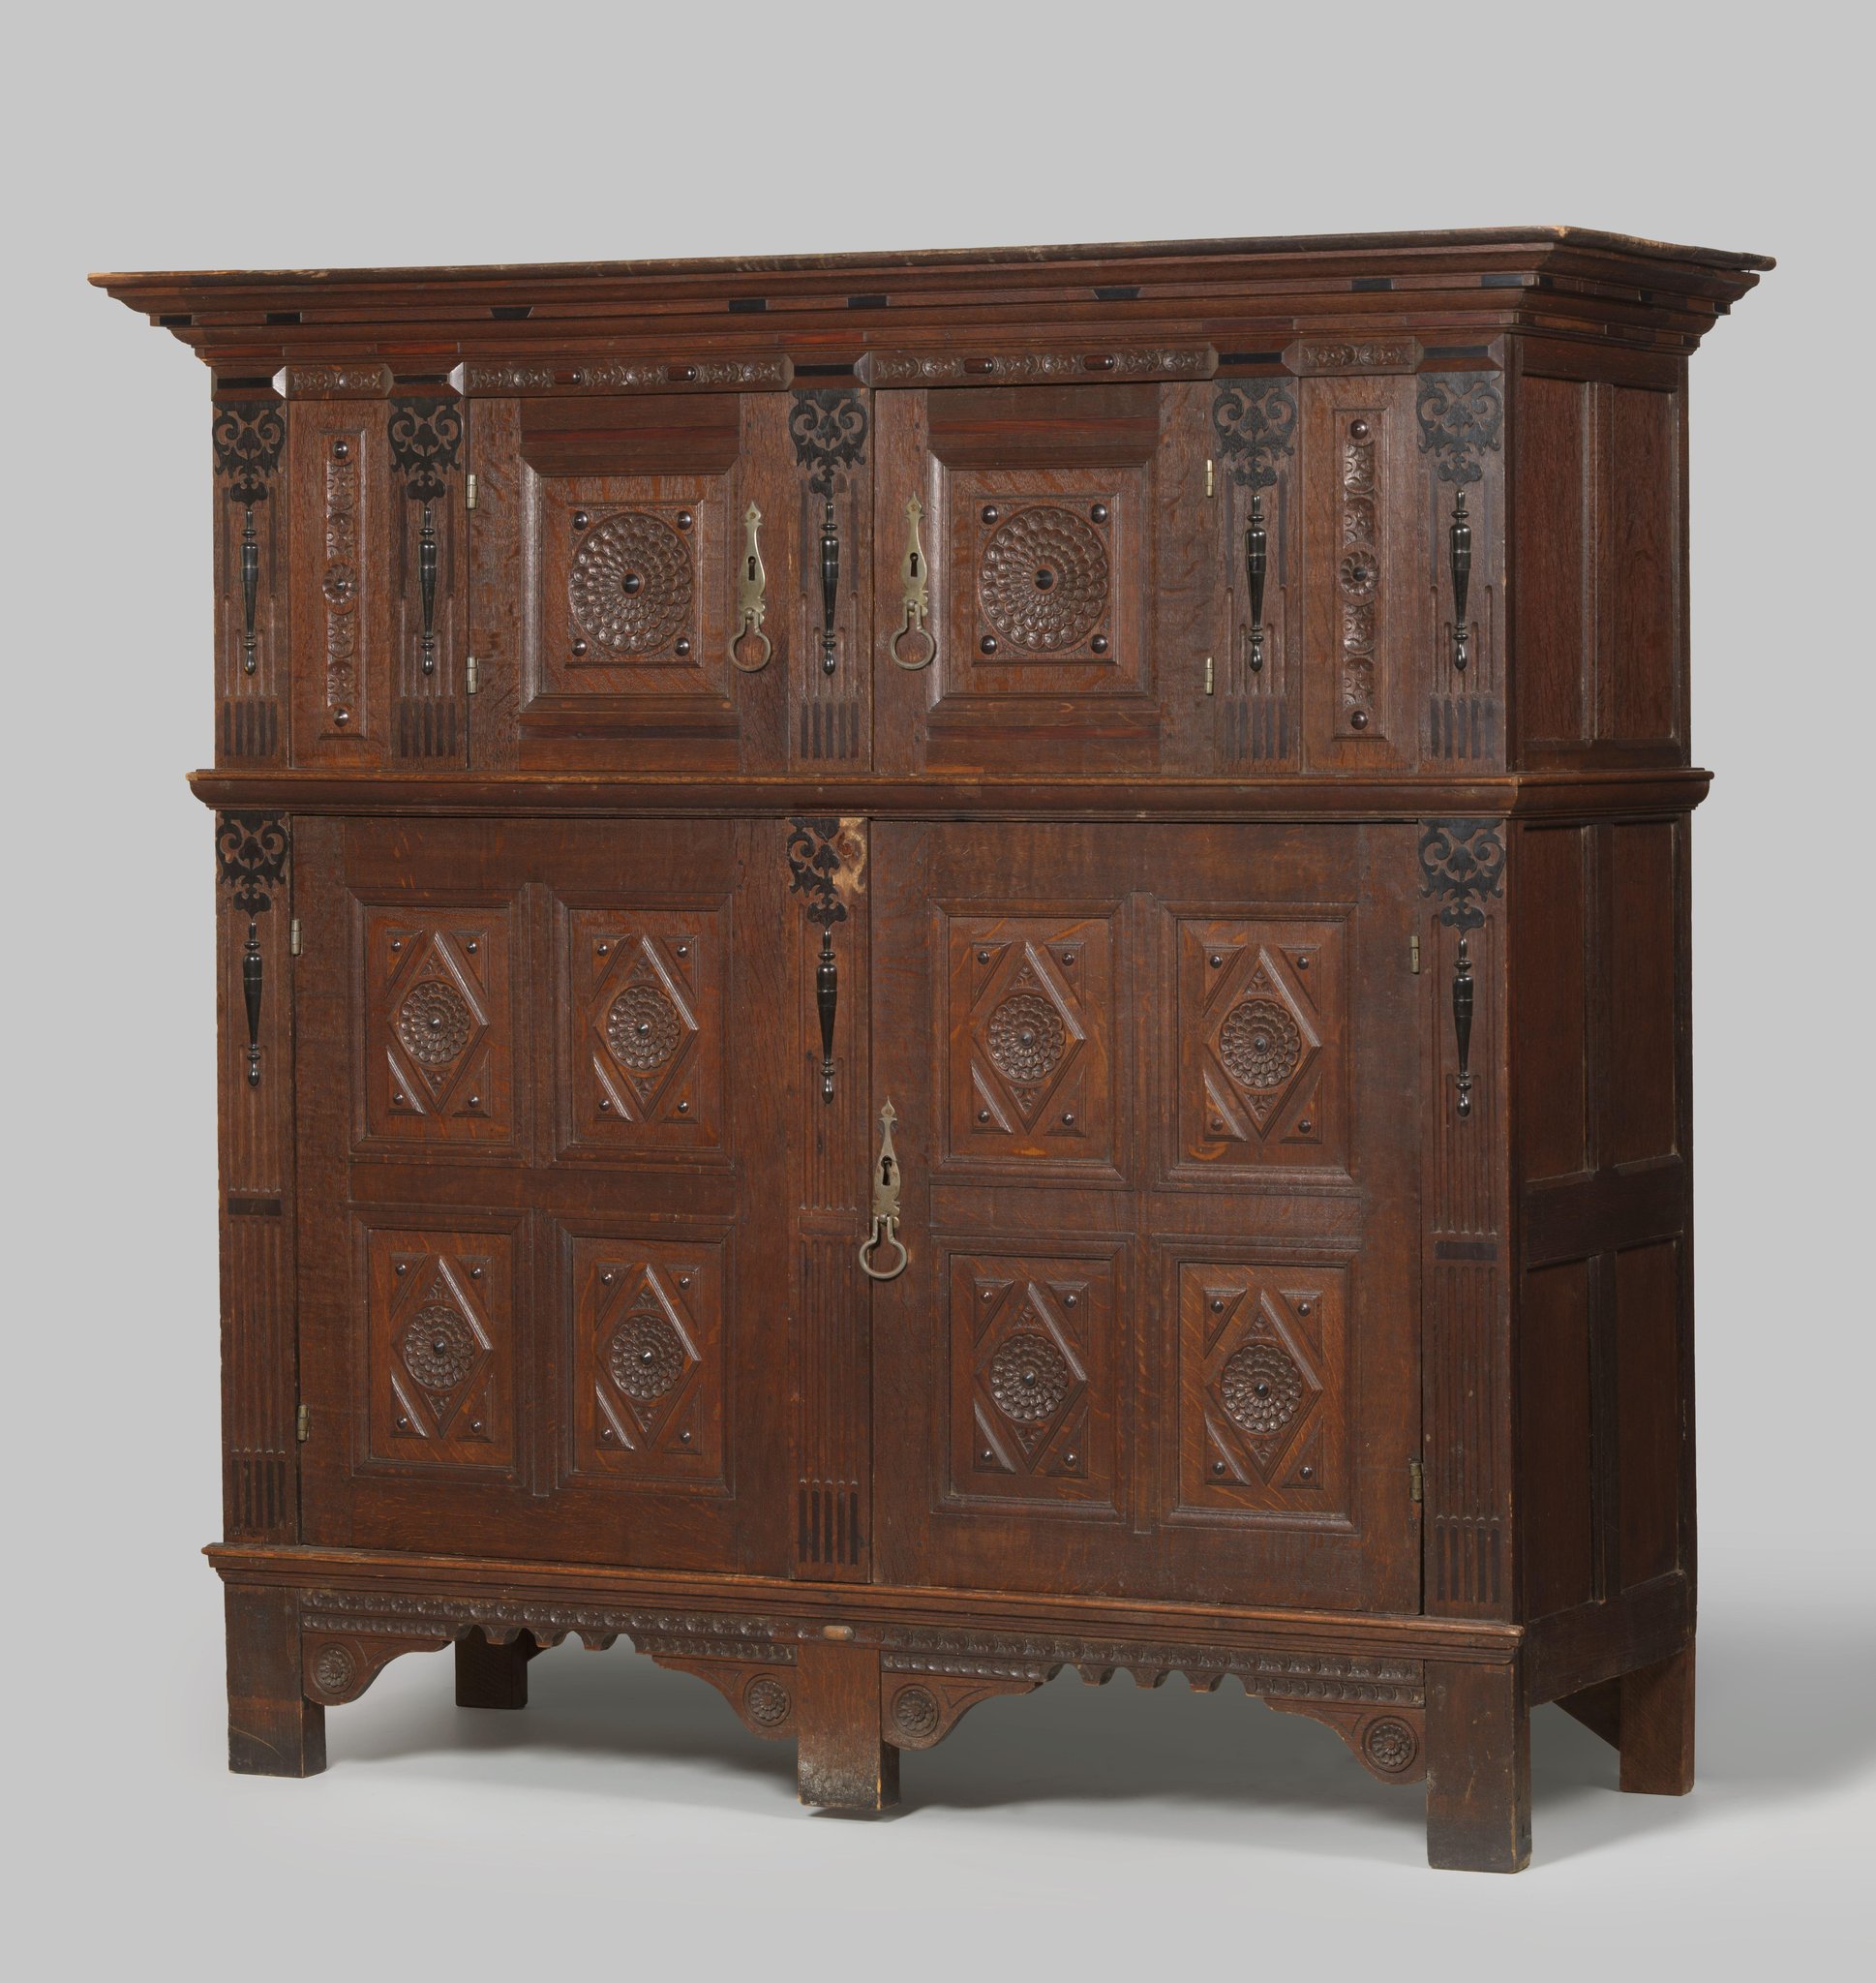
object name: furniture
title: Vierdeurskast met panelen met rozetten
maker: Anonymous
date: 1499-1699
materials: wood, metal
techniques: staining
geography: northern netherlands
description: Vierdeurskast van eike- en ebbenhout. De drie stijlen van de hoge onderkast en de vijf stijlen van de bovenkast vertonen een gesphanger, wortelvormig ornament, druiper en cannelures en cannelurebiezen. Tussen de bovenstijlen zijn aan de zijkanten smalle panelen met rozetachtig snijwerk aangebracht; in het midden twee deuren met een grote rozet binnen een vierkante lijst. De onderdeuren vertonen ieder vier panelen met rozetten binnen ruitvormige lijsten. Onderregel met consolevormige hoekstukken.